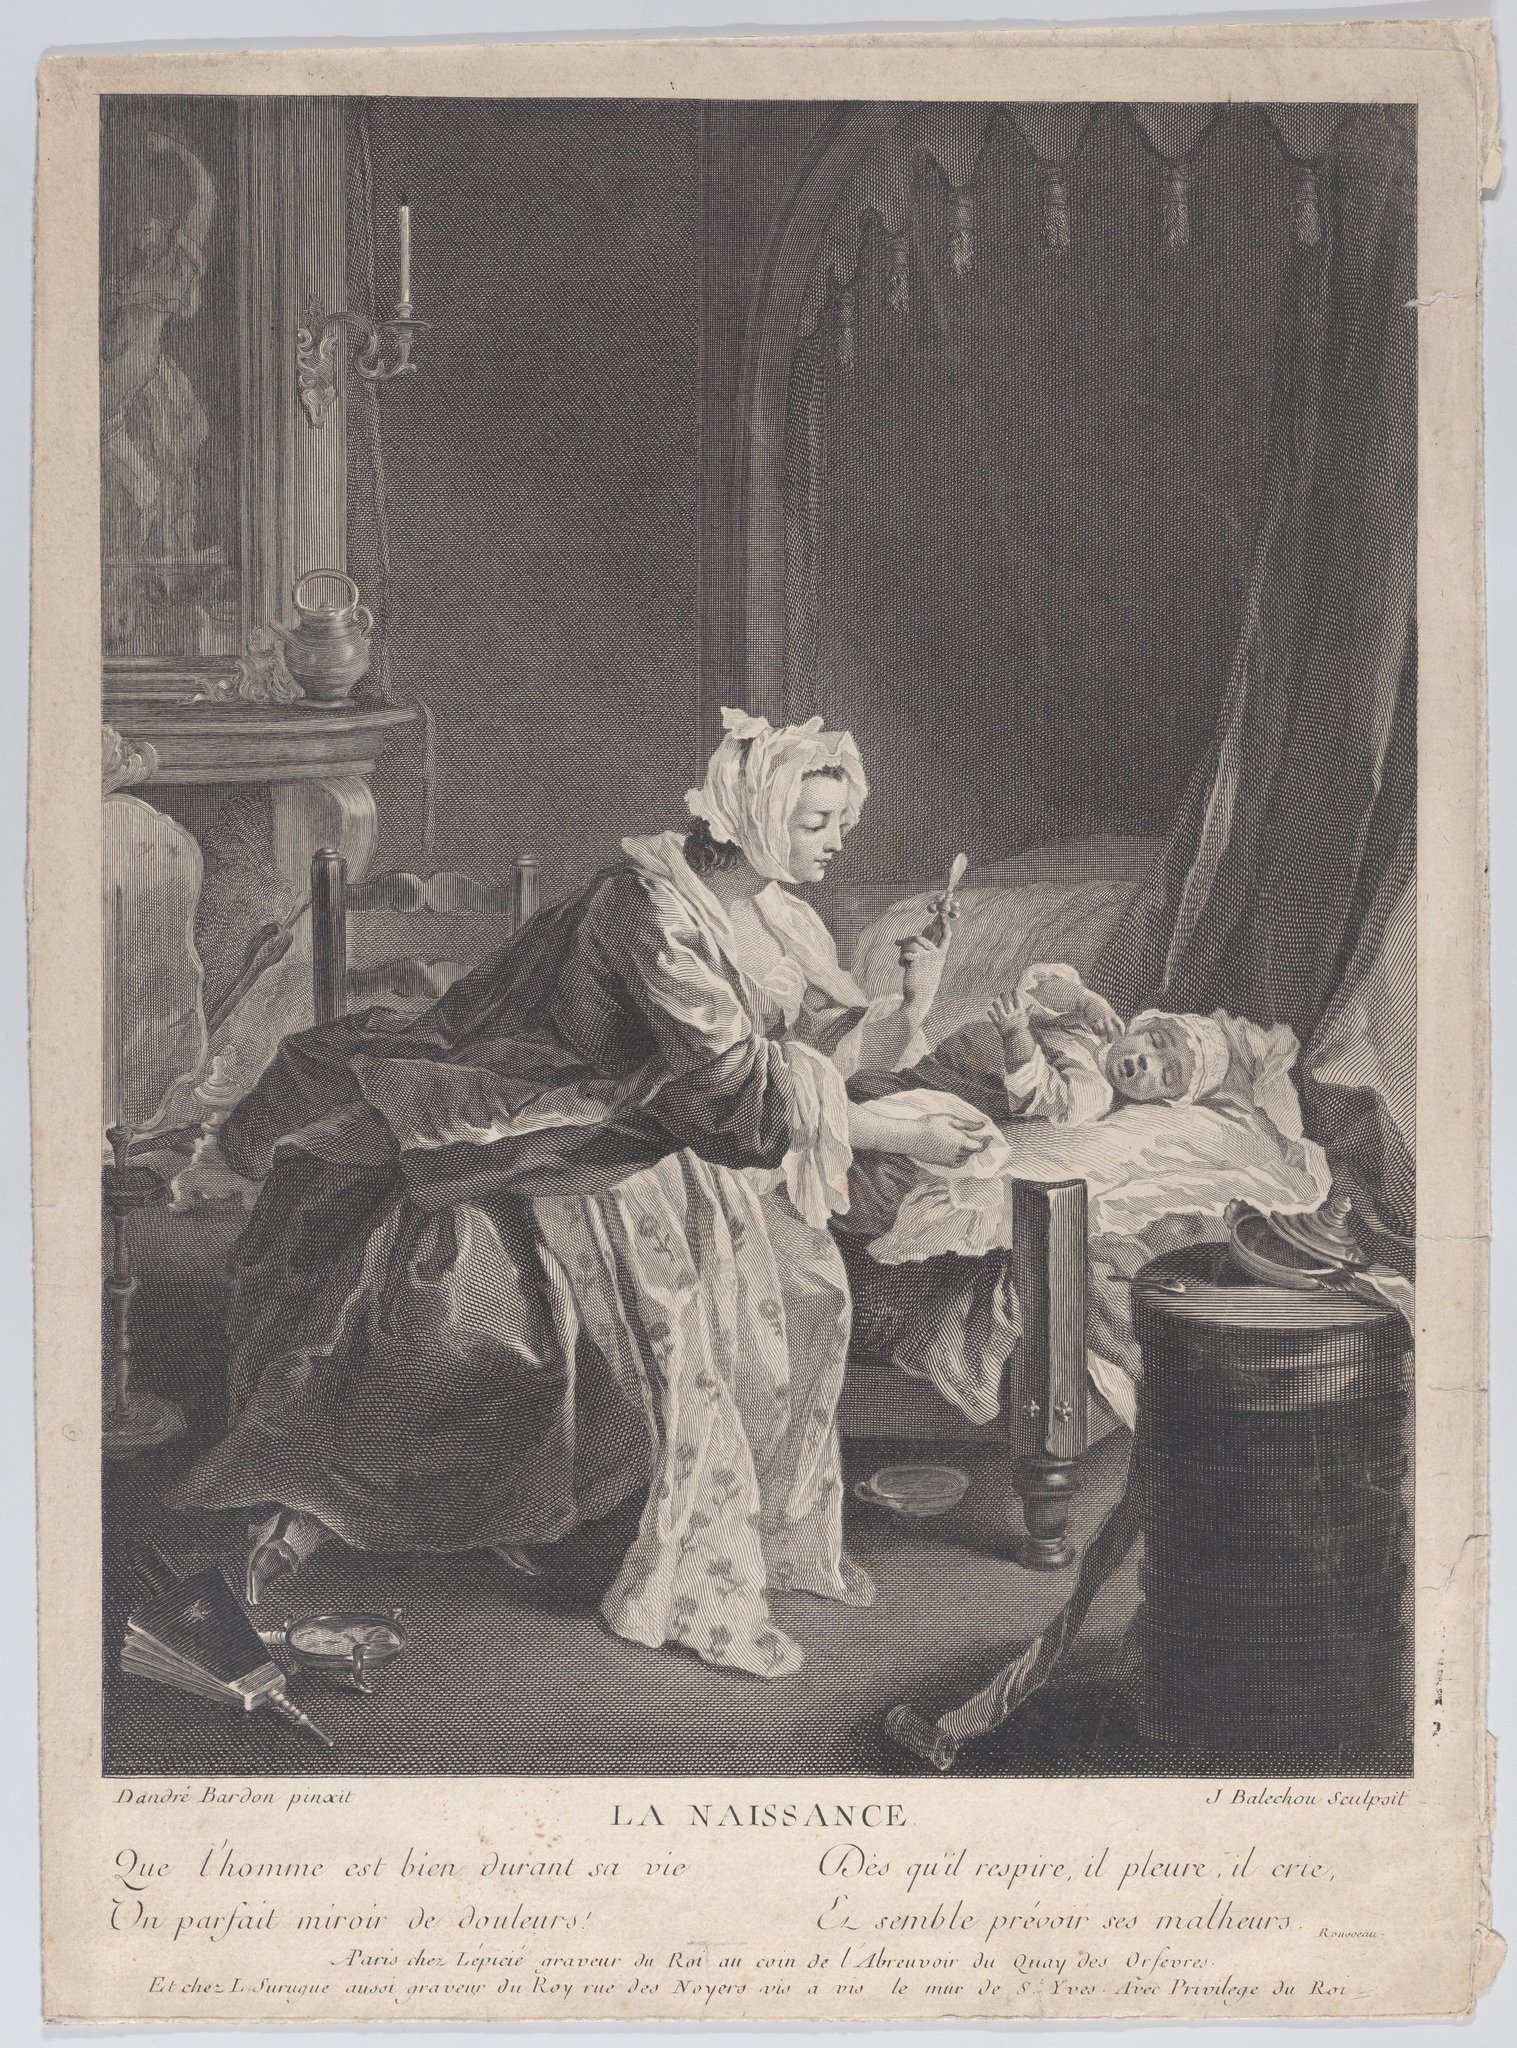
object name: print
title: La Naissance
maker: jean-joseph baléchou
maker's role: artist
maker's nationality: french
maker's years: 1716-1764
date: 1744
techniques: engraving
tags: interiors,infants,women